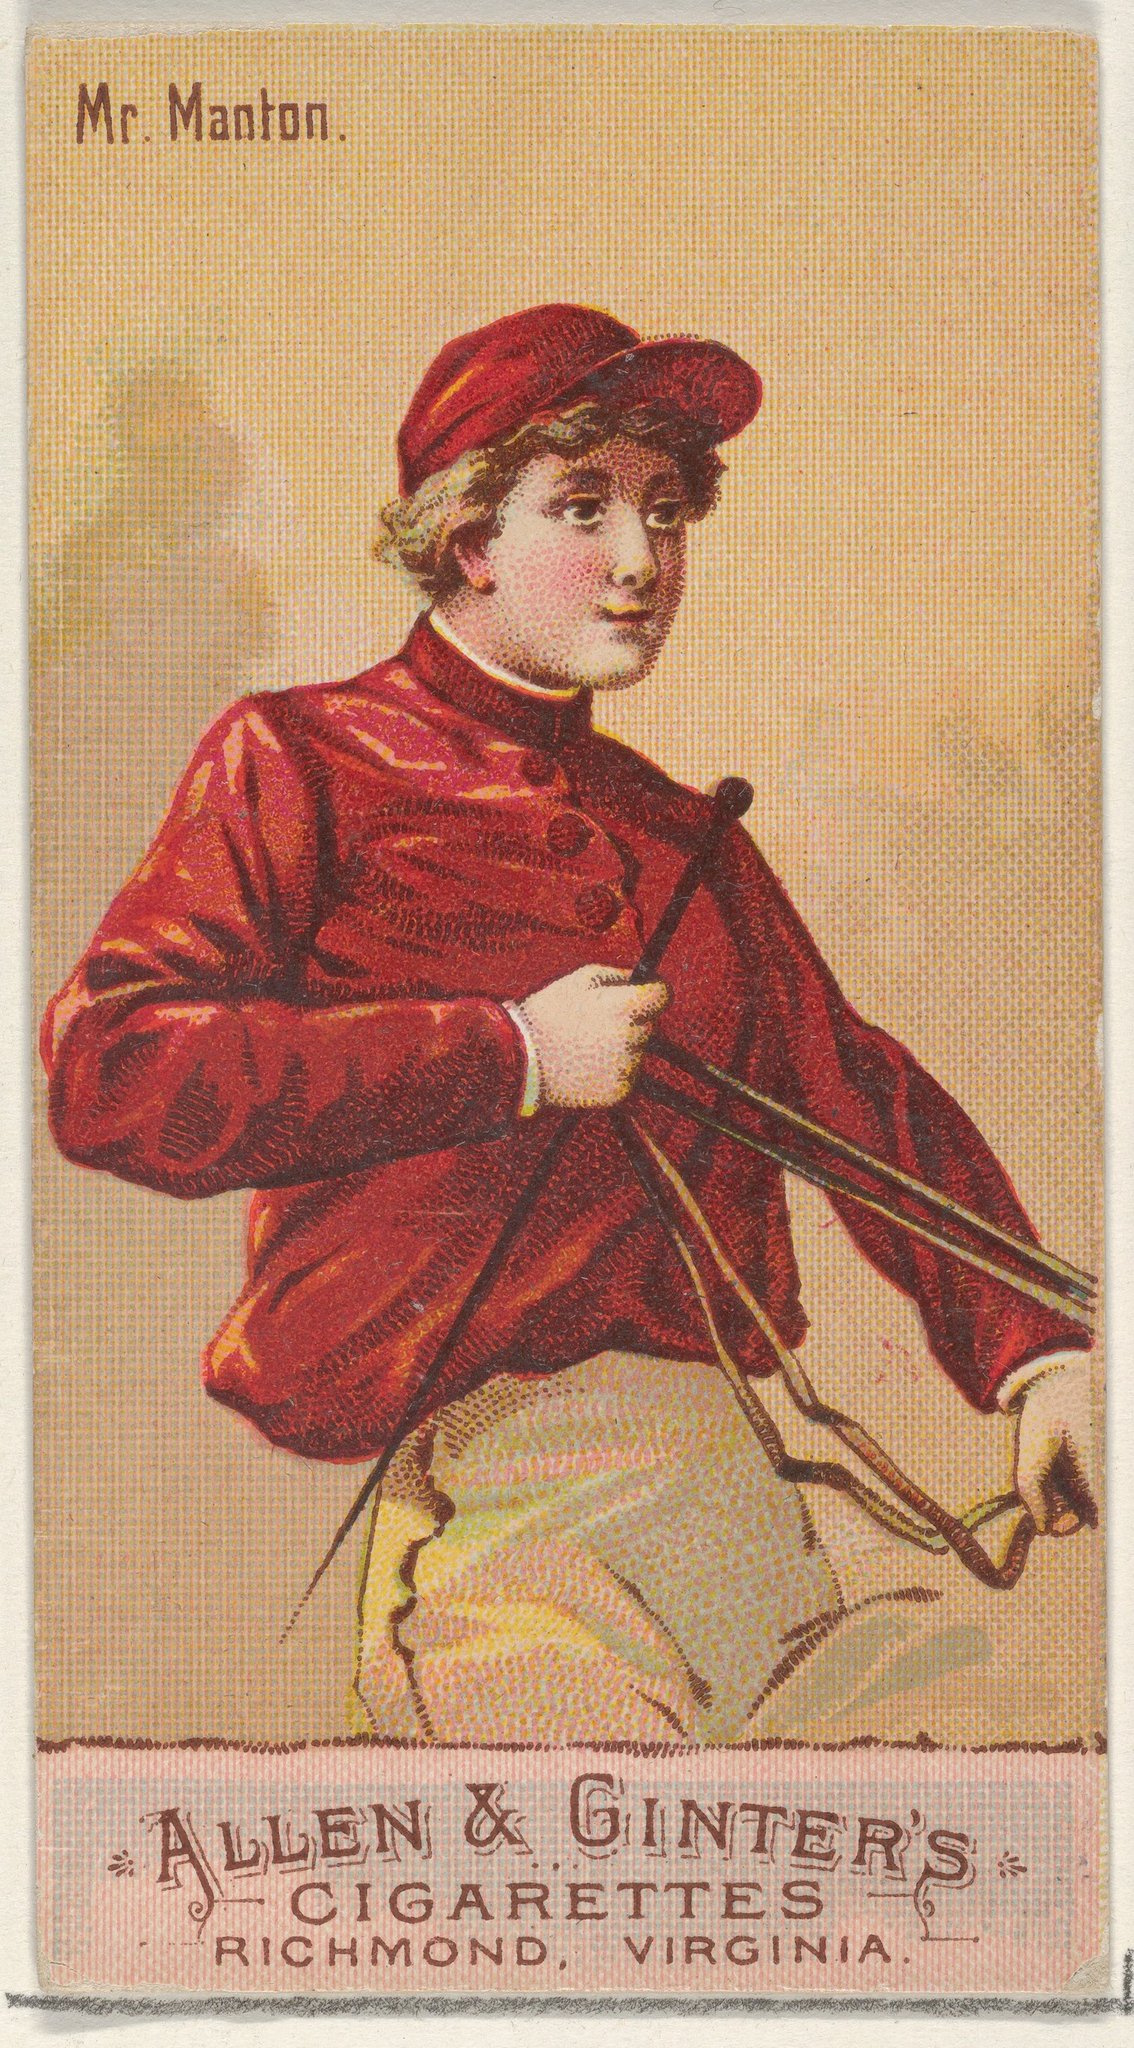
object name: print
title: Mr. Manton, from the Racing Colors of the World series (N22b) for Allen & Ginter Cigarettes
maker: allen & ginter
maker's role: publisher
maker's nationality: american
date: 1888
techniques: color lithograph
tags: men,jockeys